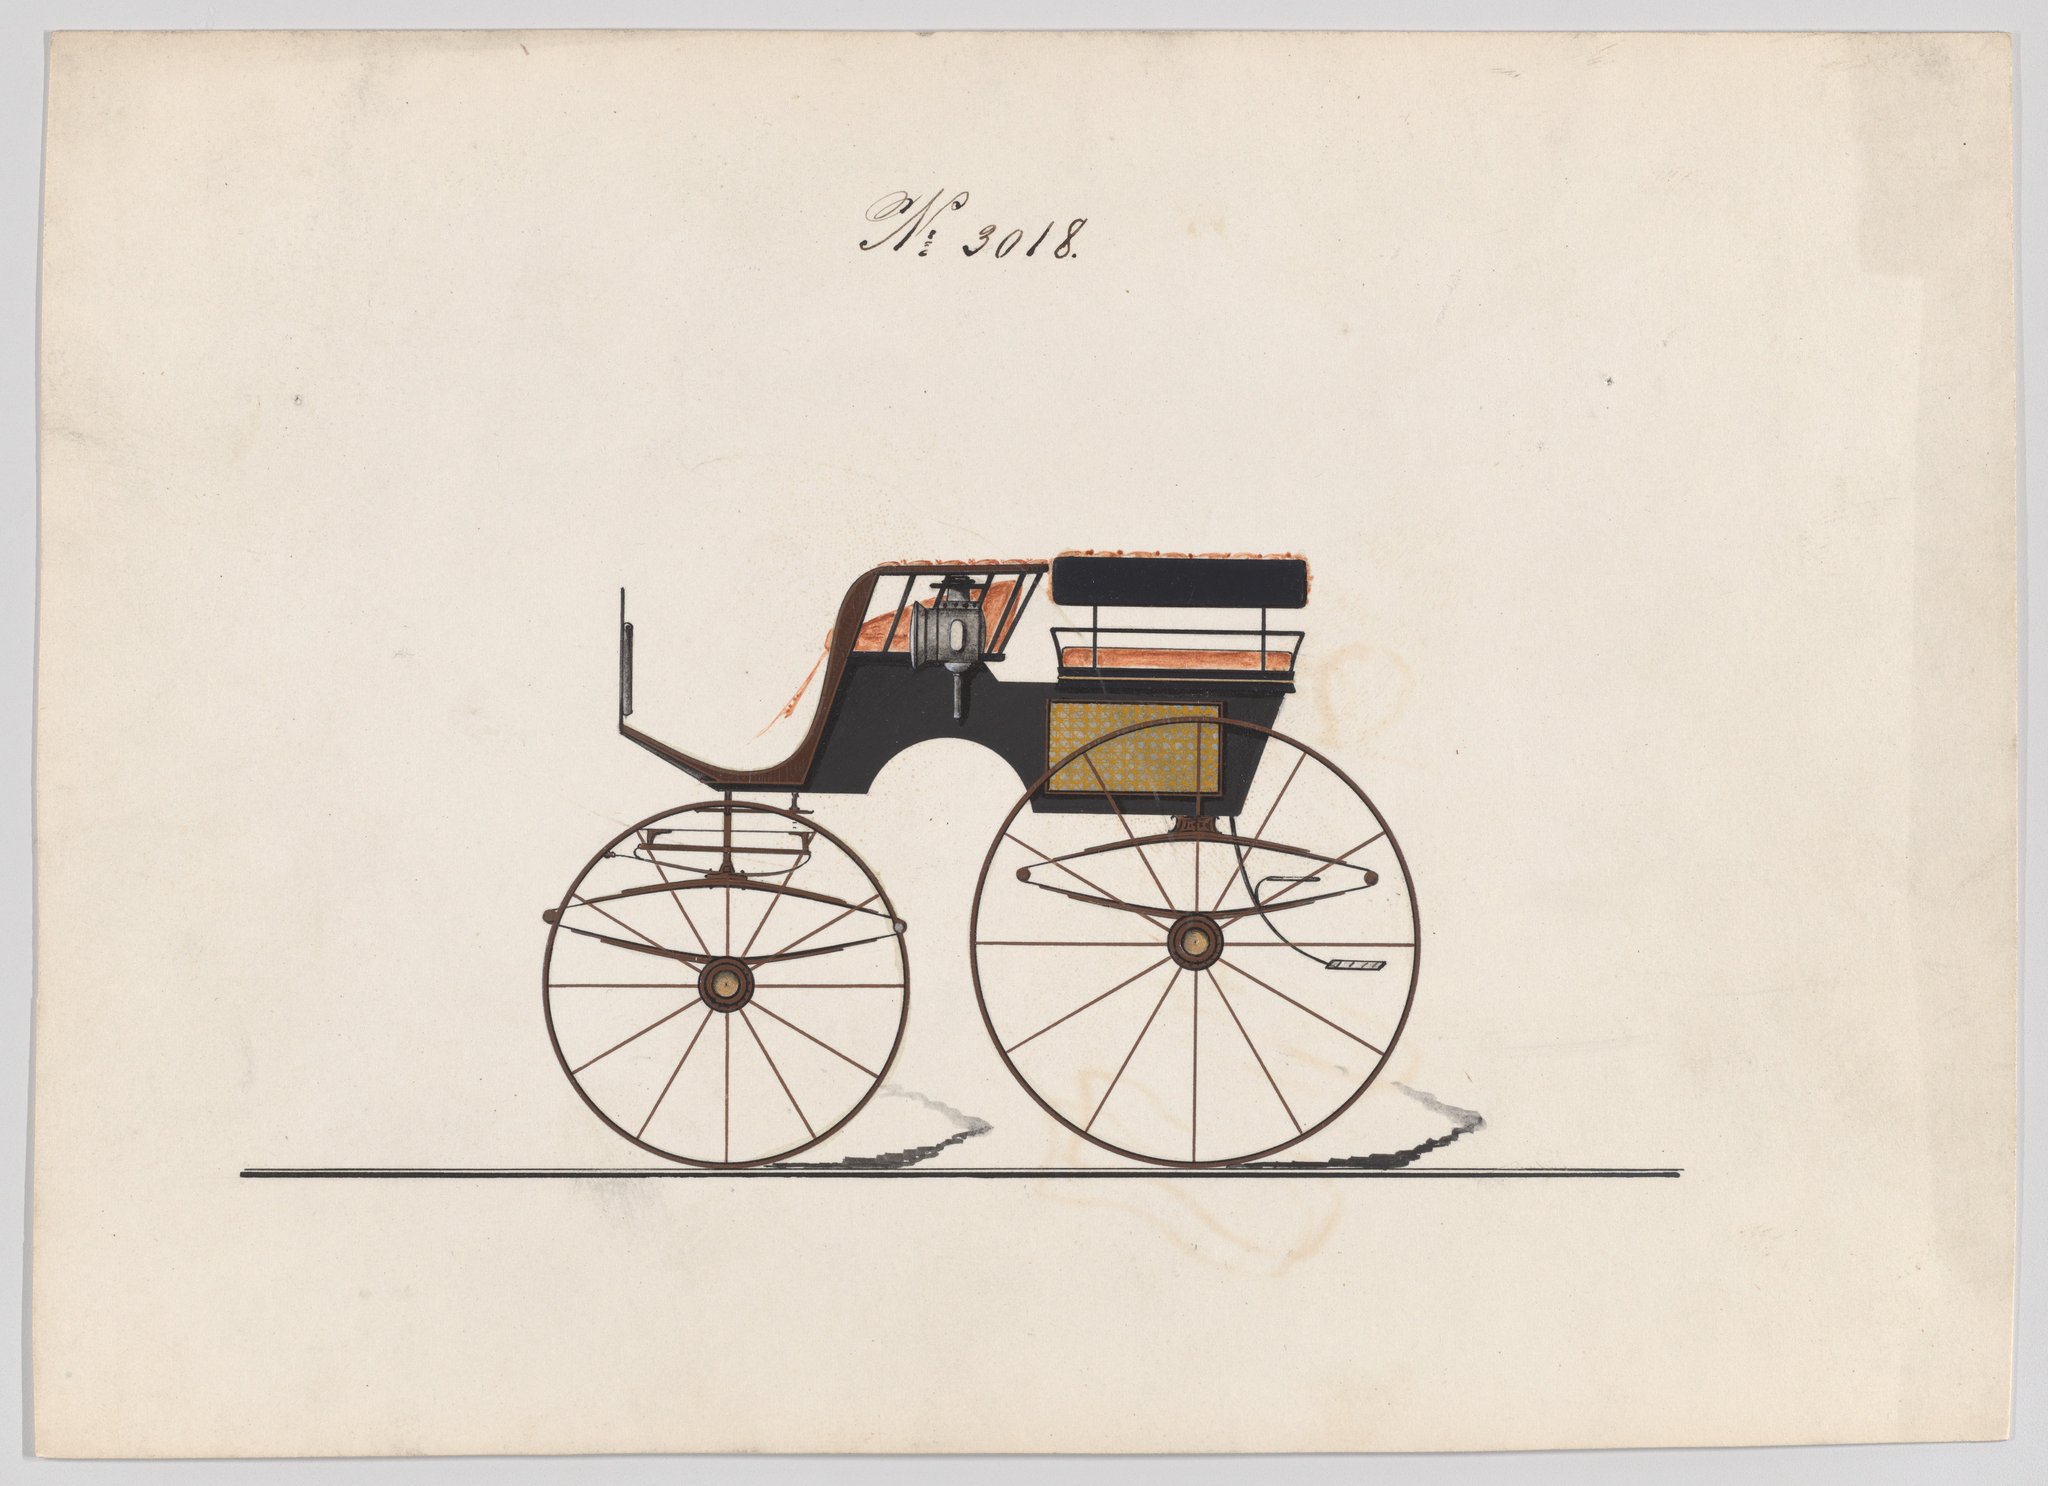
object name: drawing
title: Design for Dog Cart or 2 Wheeler, no. 3018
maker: brewster & co.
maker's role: manufacturer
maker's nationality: american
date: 1874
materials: gouache, gum arabic, ink, watercolor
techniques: pen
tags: carriages